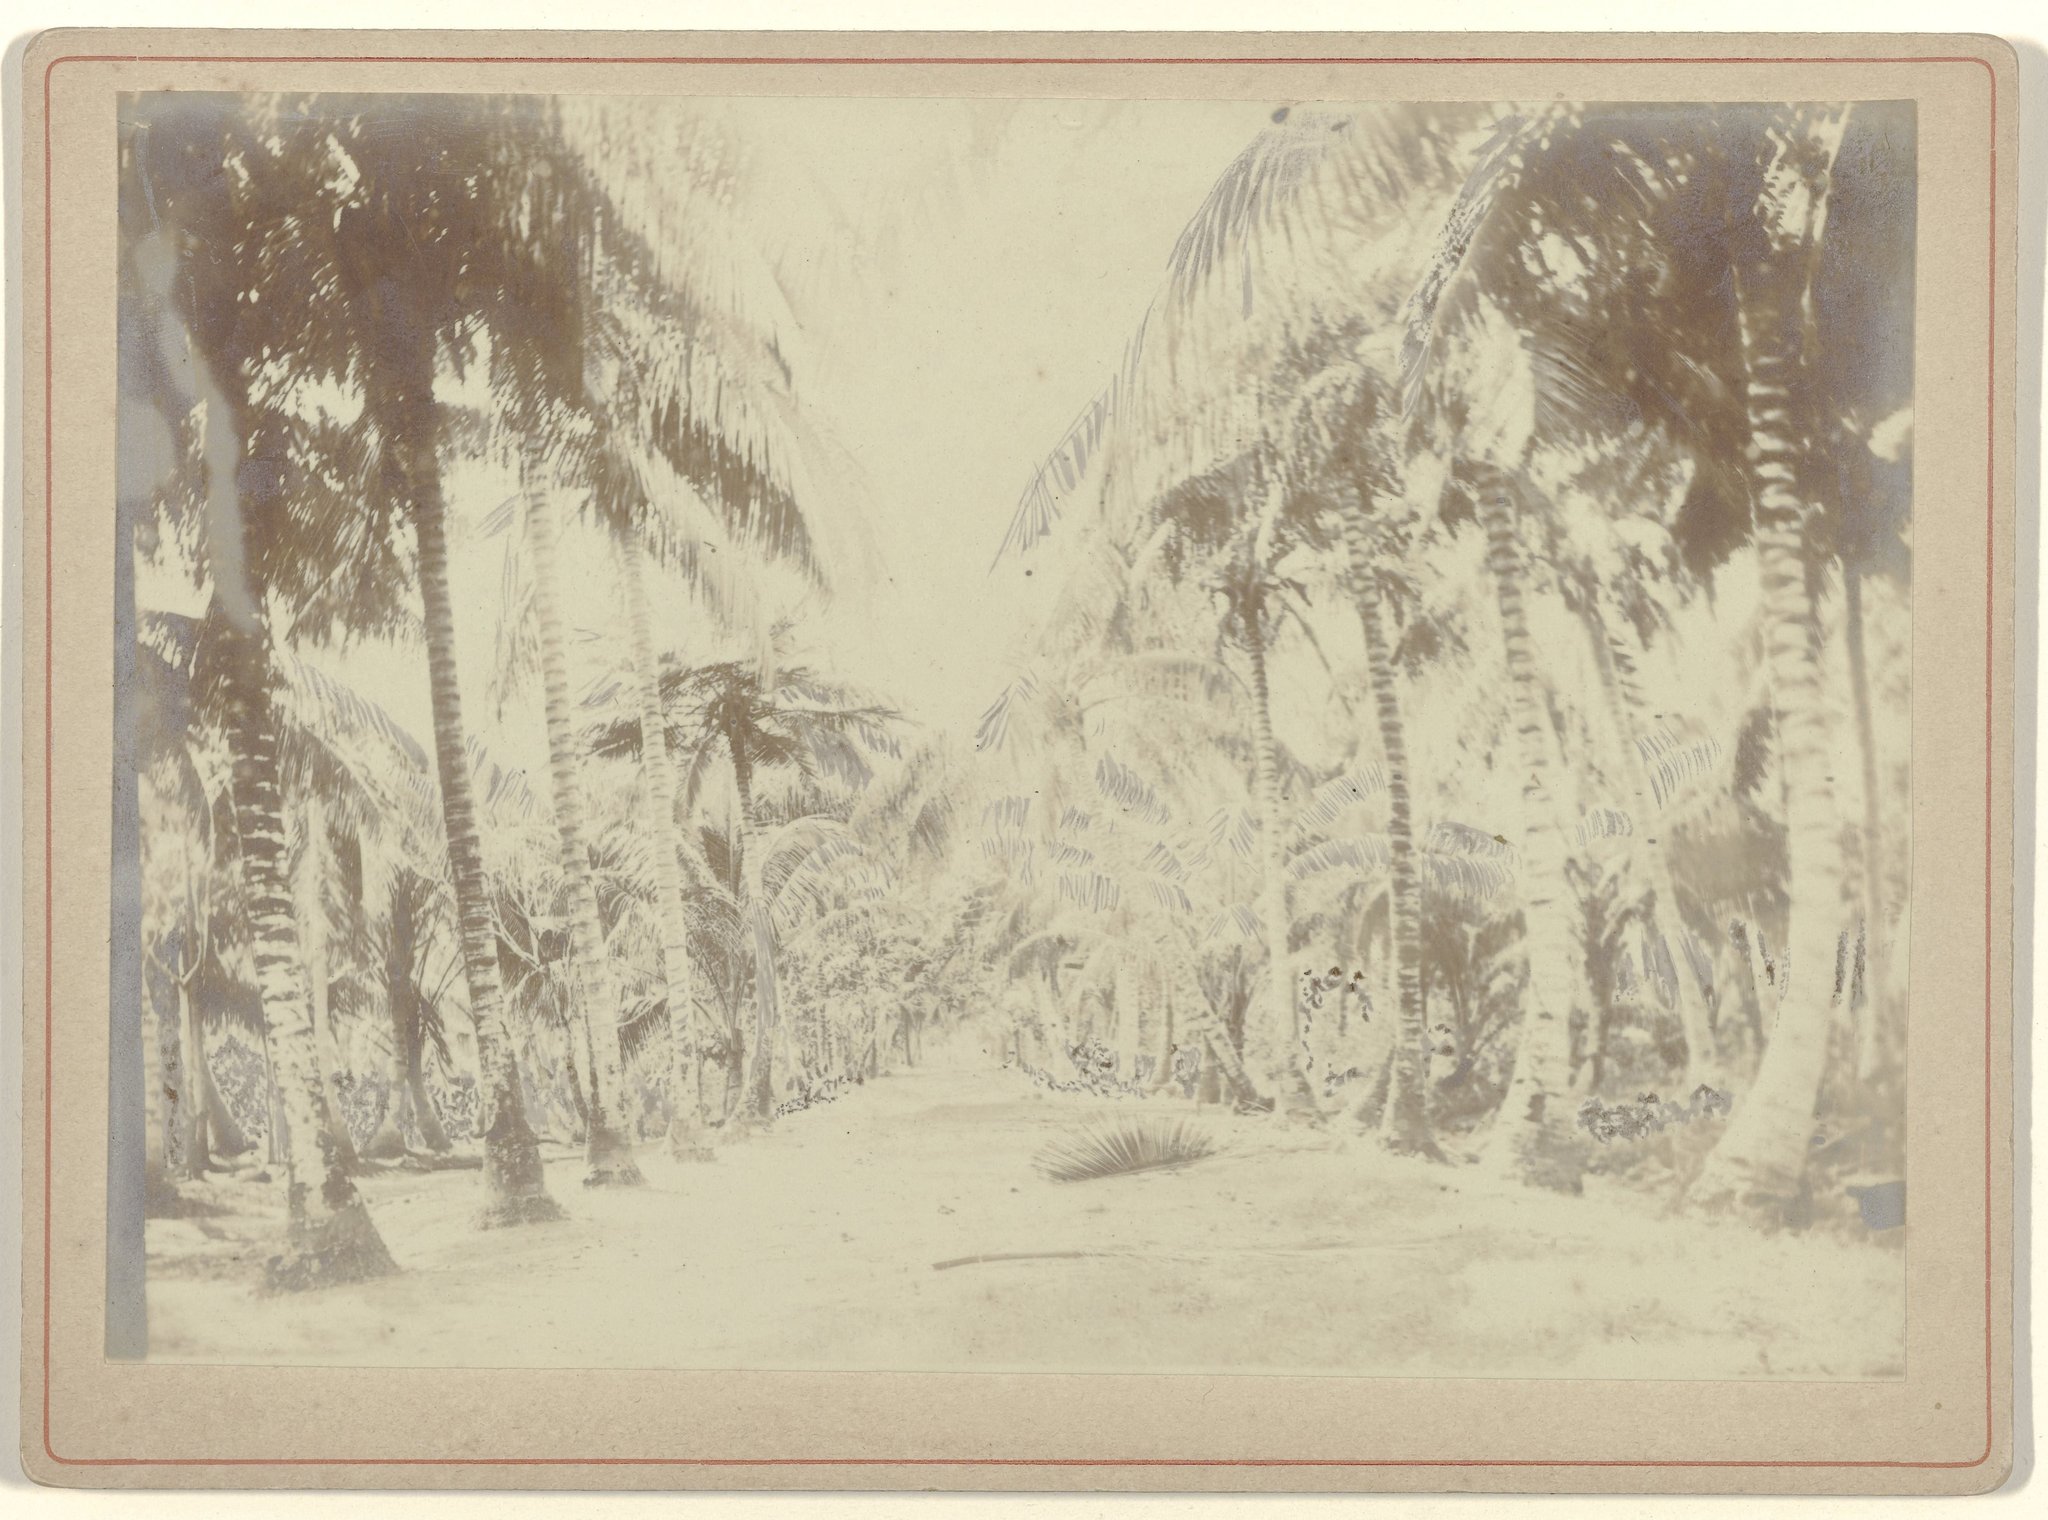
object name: photograph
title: Een palmentuin of plantage in Suriname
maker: Anonymous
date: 1900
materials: cardboard, photographic support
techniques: photography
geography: suriname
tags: plantation, trees: palm-tree, suriname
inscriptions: annotation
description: Een palmentuin of plantage met middenpad, ergens in Suriname. Palmbladeren en struikgewas zijn bij getekend. Onderdeel van een groep objecten afkomstig van de familie Wesenhagen in Suriname.